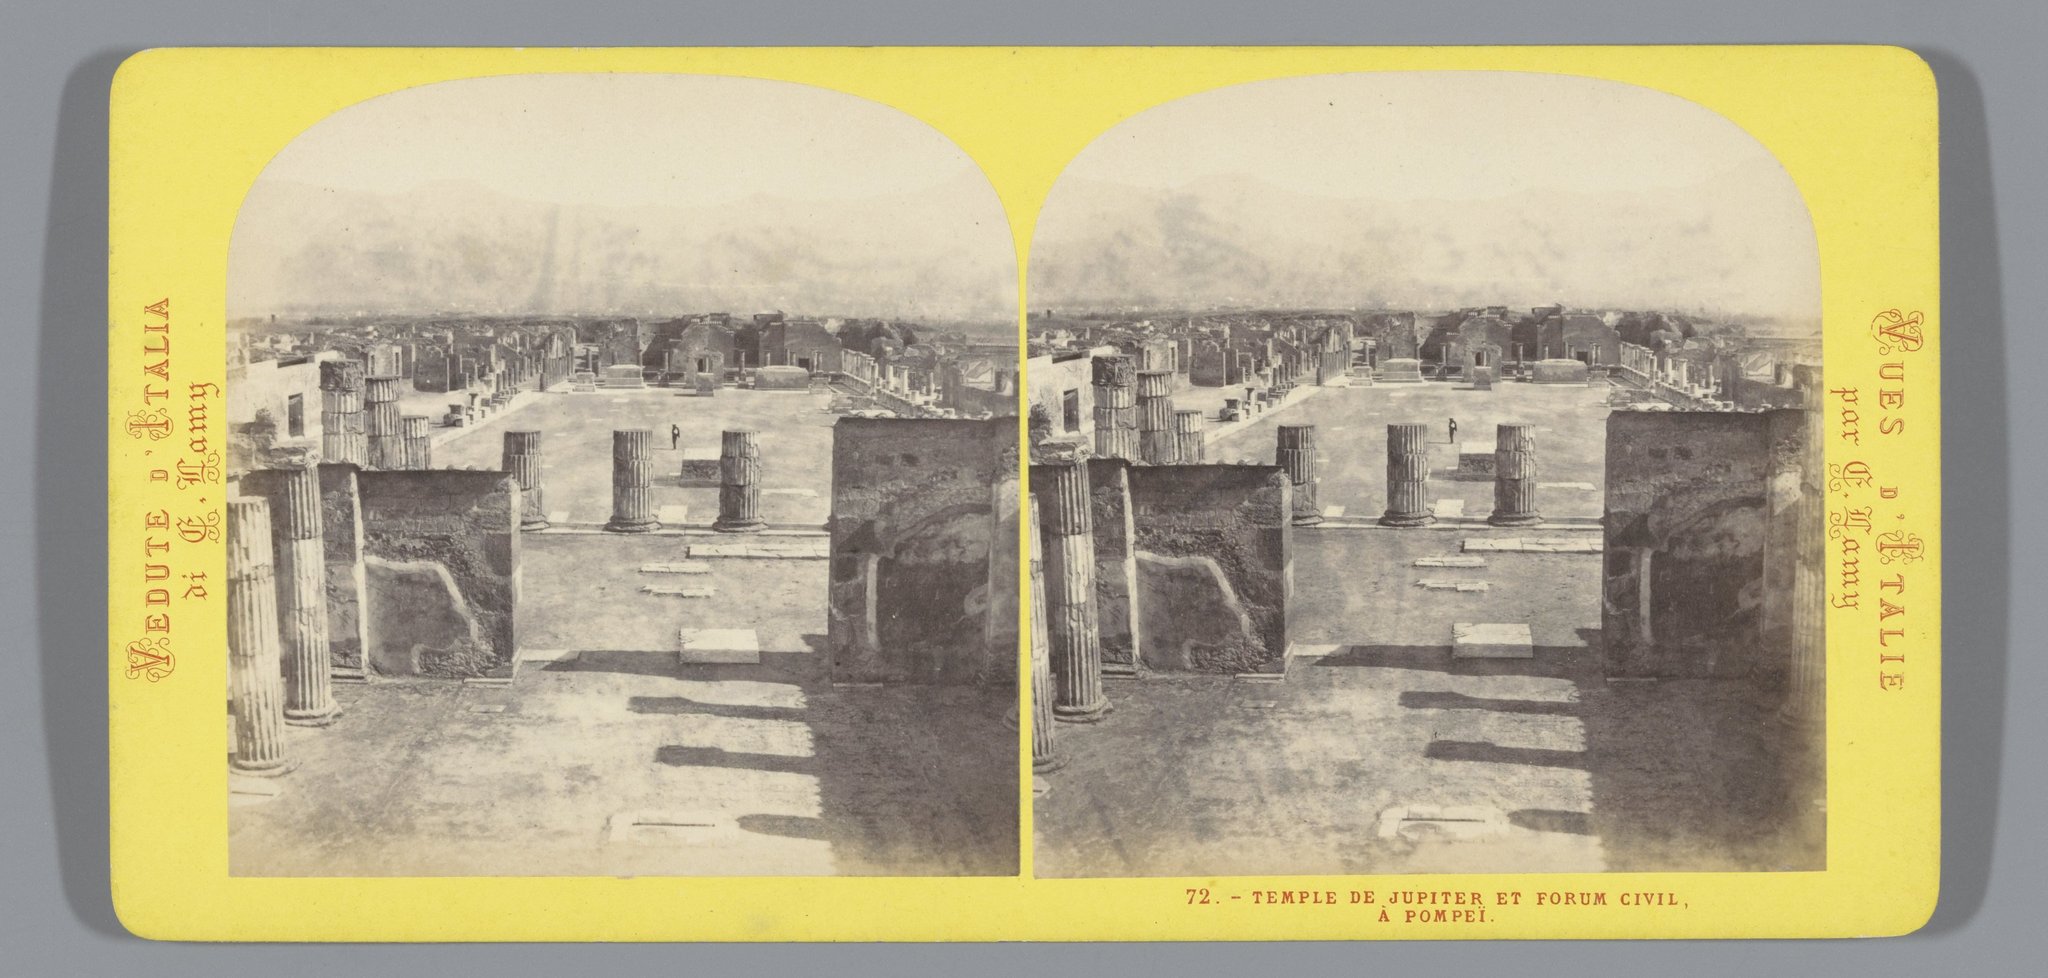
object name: stereograph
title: Vedute d'Italia / Vues d'Italie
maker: ernest eléonor pierre lamy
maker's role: publisher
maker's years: 1828-1900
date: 1861-1878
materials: cardboard, paper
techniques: albumen print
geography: pompeii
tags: temple, shrine ~ roman religion, excavation ~ archaeology, pompeii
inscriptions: number: ‘72.’